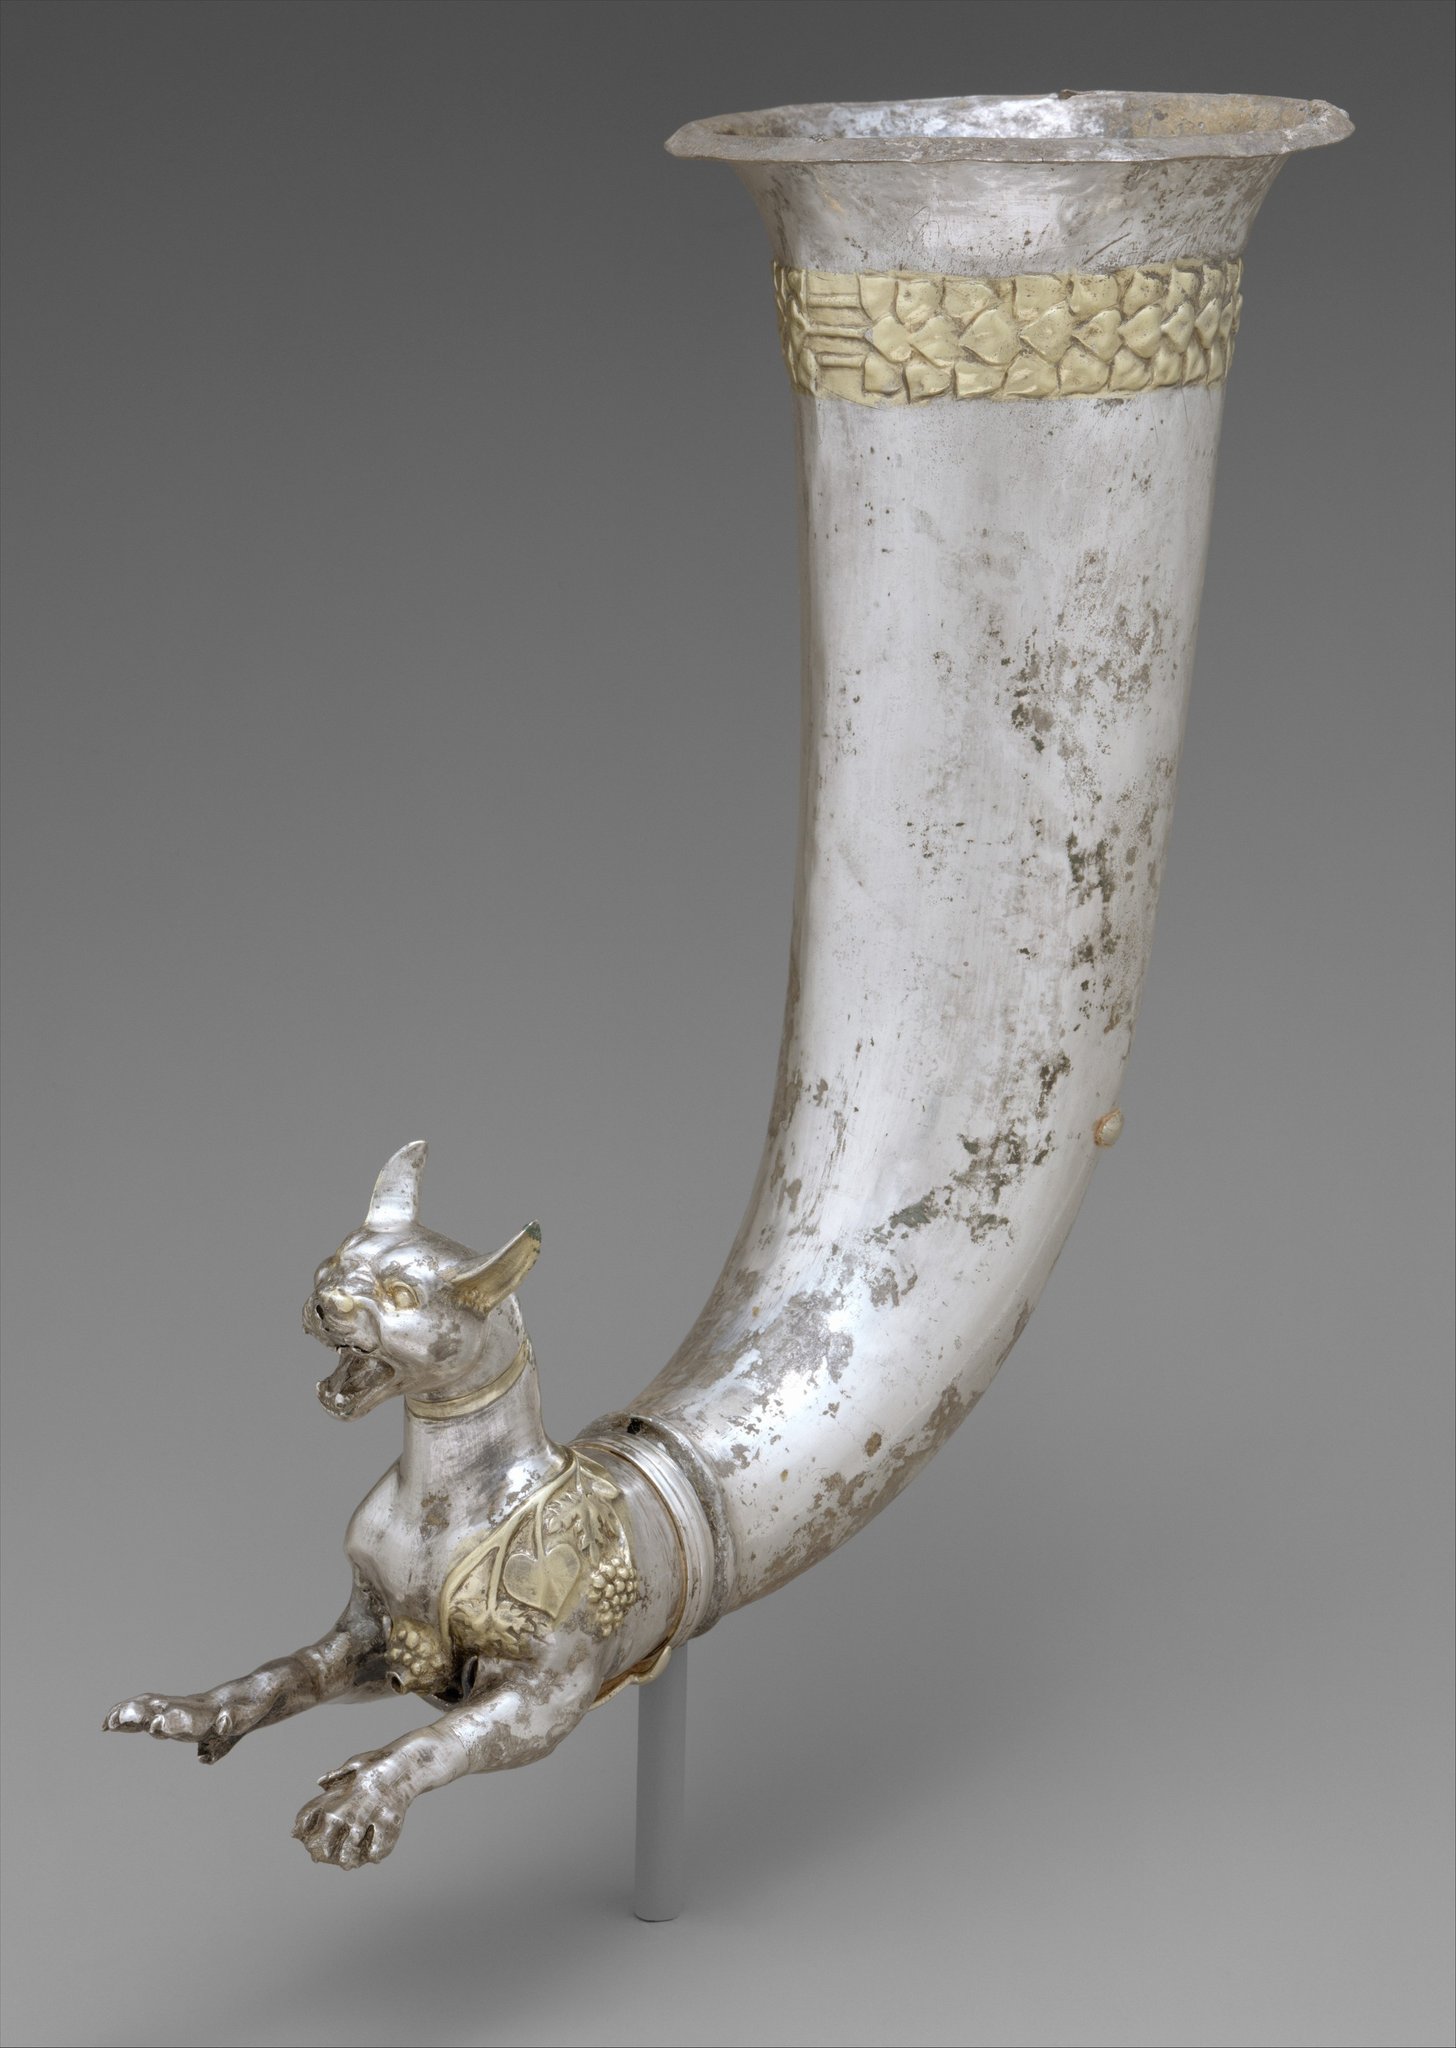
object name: rhyton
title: Rhyton terminating in the forepart of a wild cat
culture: parthian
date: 100-1 BCE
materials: mercury, silver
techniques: gilding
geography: iran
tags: grapes,cats